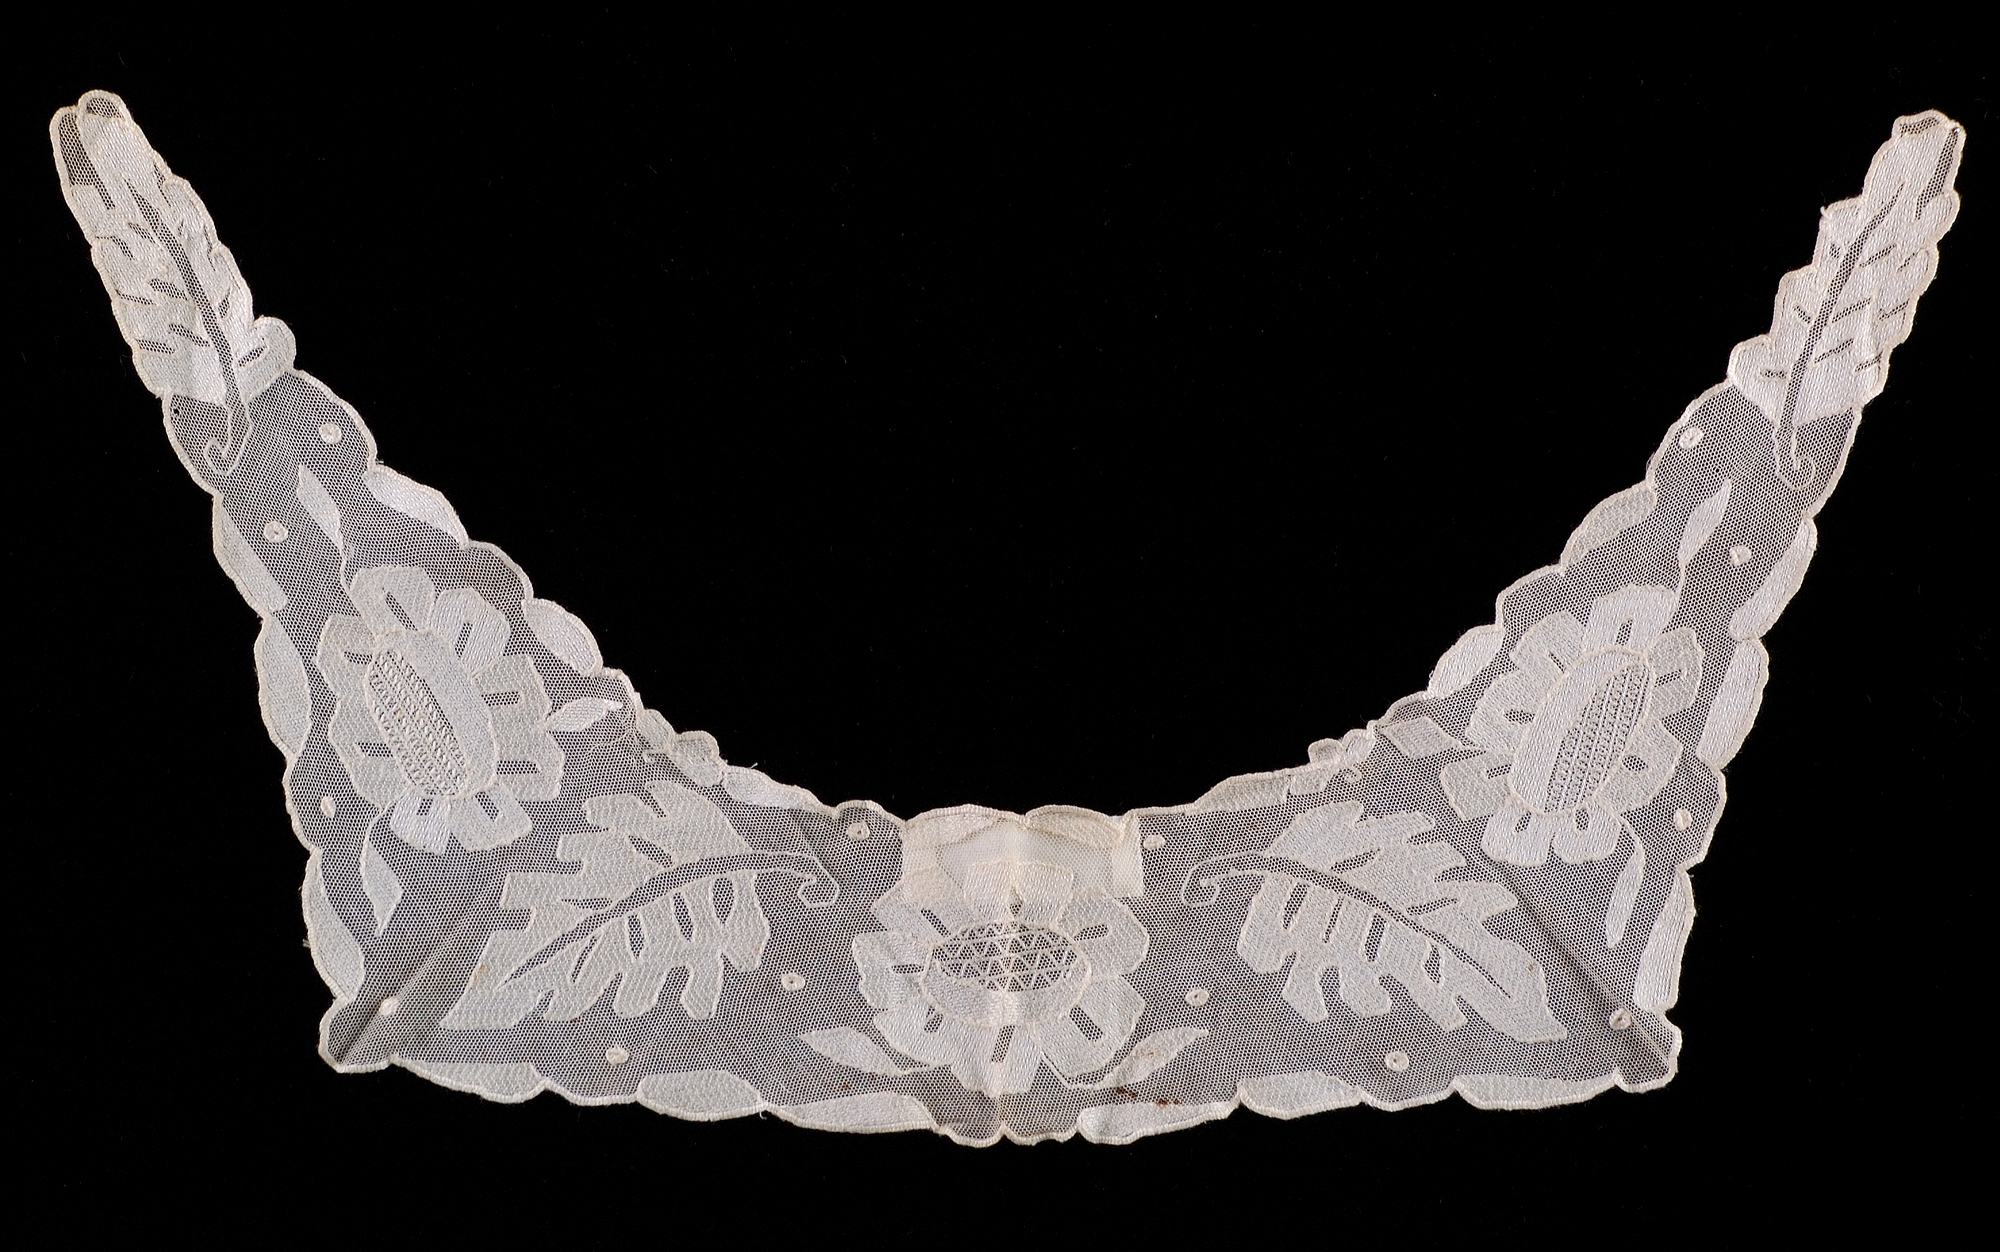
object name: collar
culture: scottish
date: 1845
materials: silk